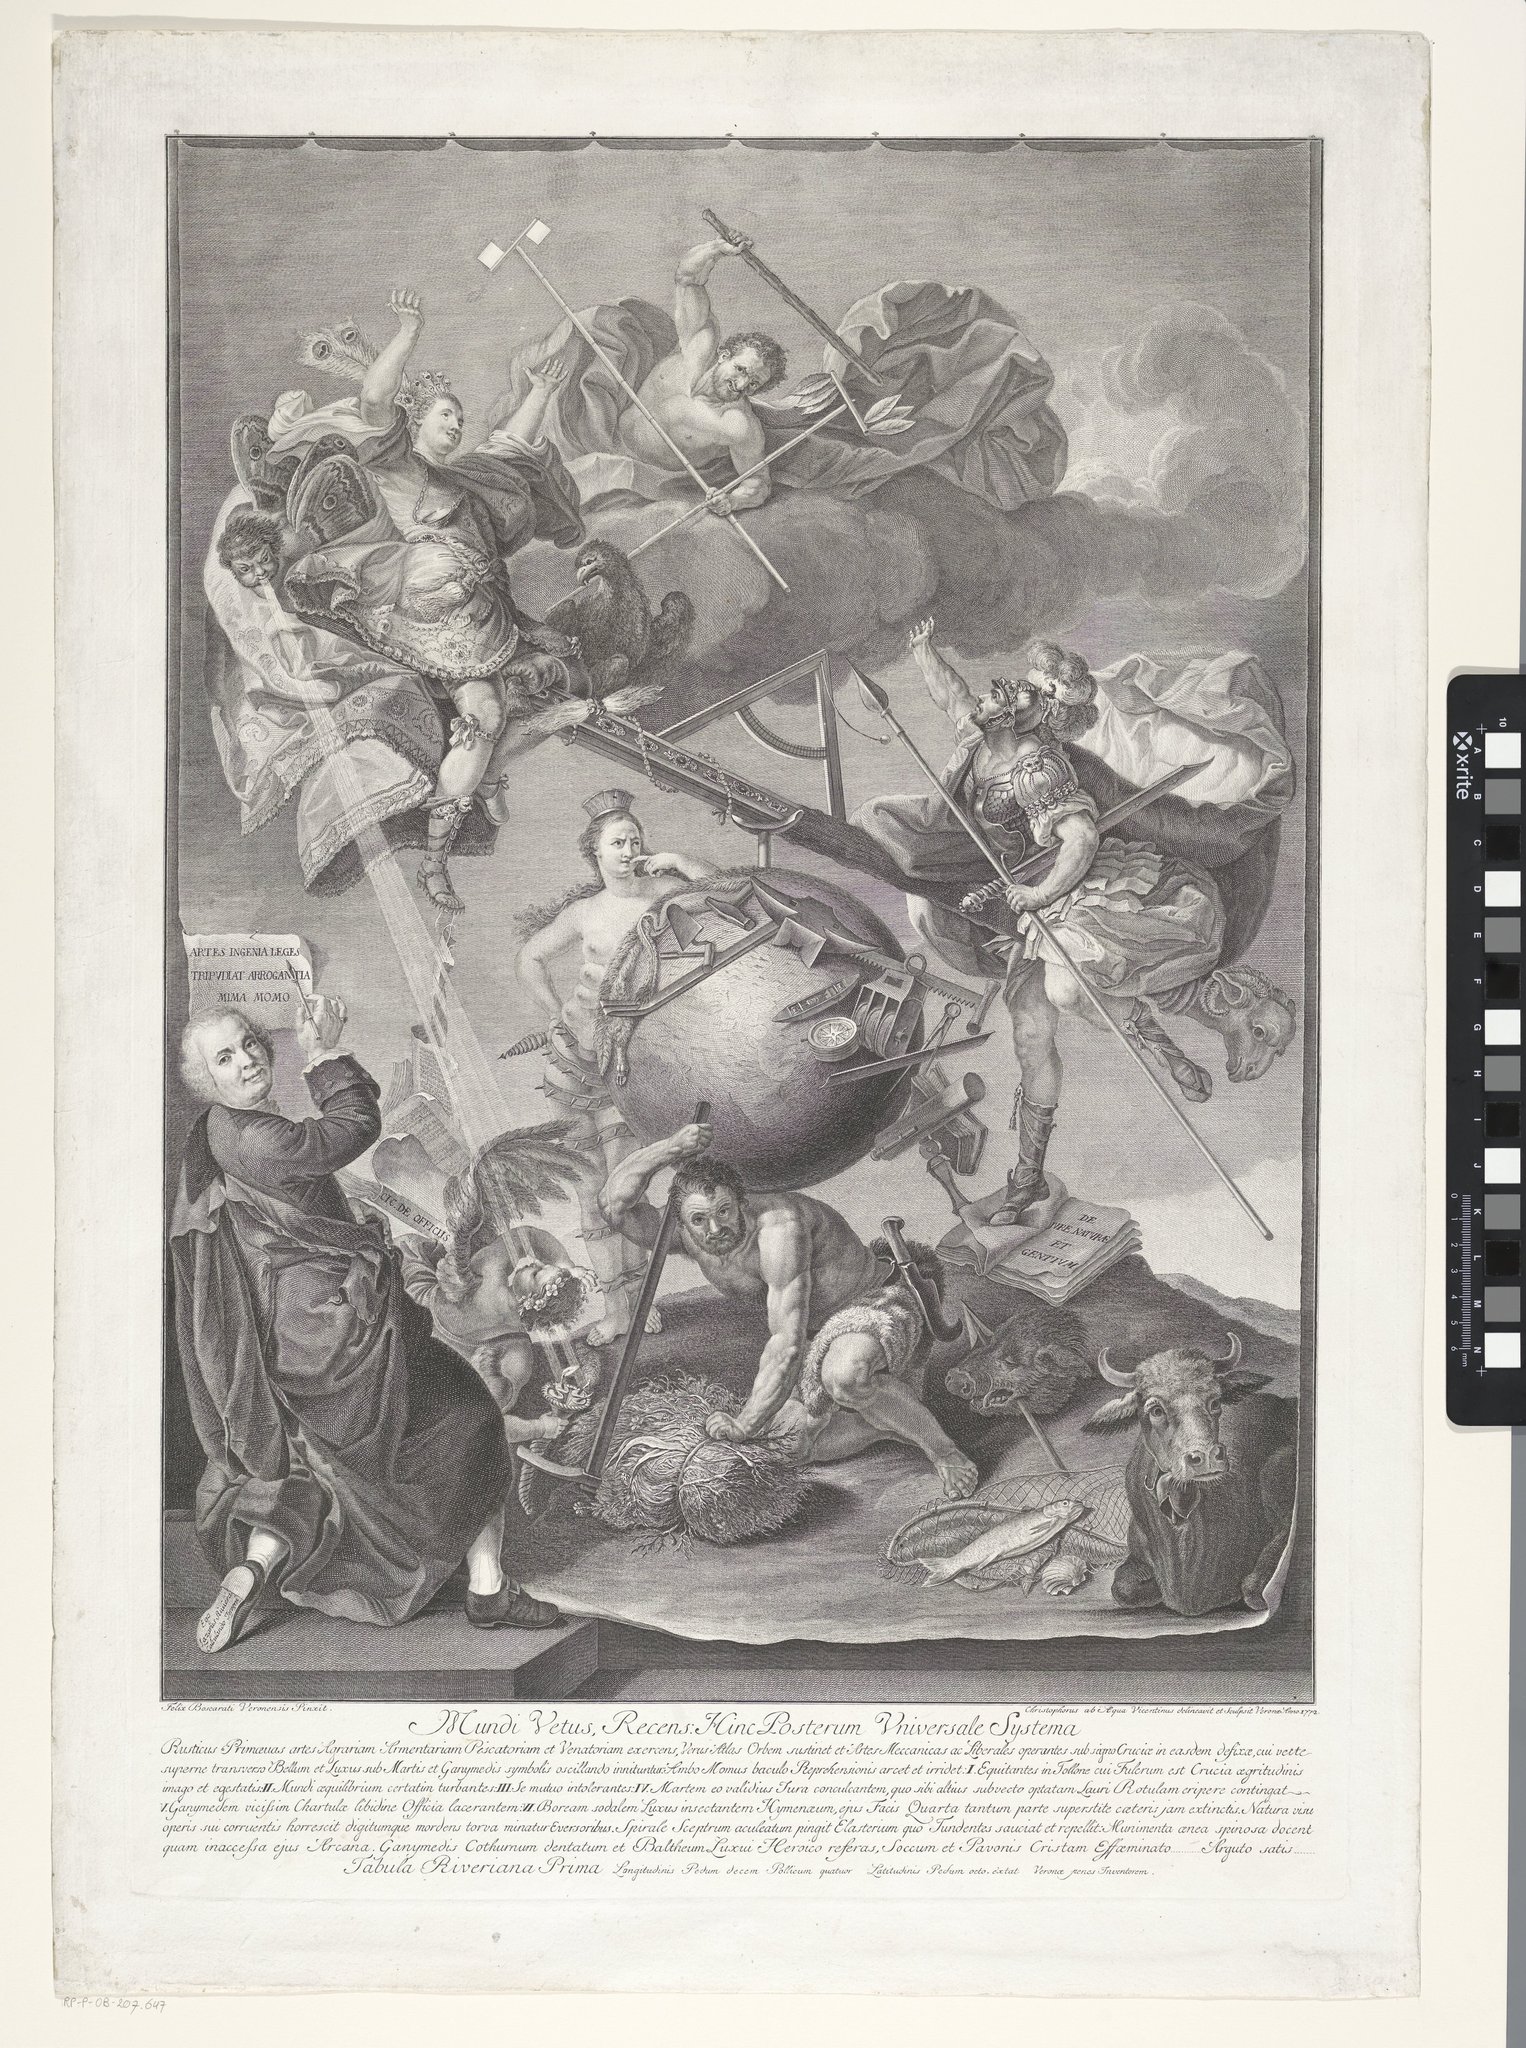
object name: print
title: Allegorie op de orde van het universum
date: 1772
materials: paper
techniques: engraving, etching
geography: verona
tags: (story of) atlas - attributes, (story of) hymen(aeus), (story of) mars (ares), (story of) ganymede, the universe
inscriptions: collector's mark: Lugt 2760, collector's mark: Lugt 2228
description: Allegorische voorstelling over de orde van het universum. Atlas zit gehurkt en draagt een globe op zijn rug. Op de globe staat een wip. Aan de ene kant van de wip zit Mars, aan de andere kant Ganymedes. Vanachter Ganymedes blaast een windgod de fakkel van Hymen (Hymenaeus) uit. Achter de globe staat een naakte vrouw met meerdere borsten en samengebonden benen. Op de voorgrond rechts een os (landbouw), een vis in een net (visserij) en de kop van een everzwijn (jacht). Boven in de lucht zweeft een man op een wolk en zwaait met een stok. De voorstelling is weergegeven op een trompe-l'oeil doek. Op de voorgrond links zit de kunstenaar geknield en voegt een tekst toe aan het doek. Tekst in het Latijn in ondermarge.